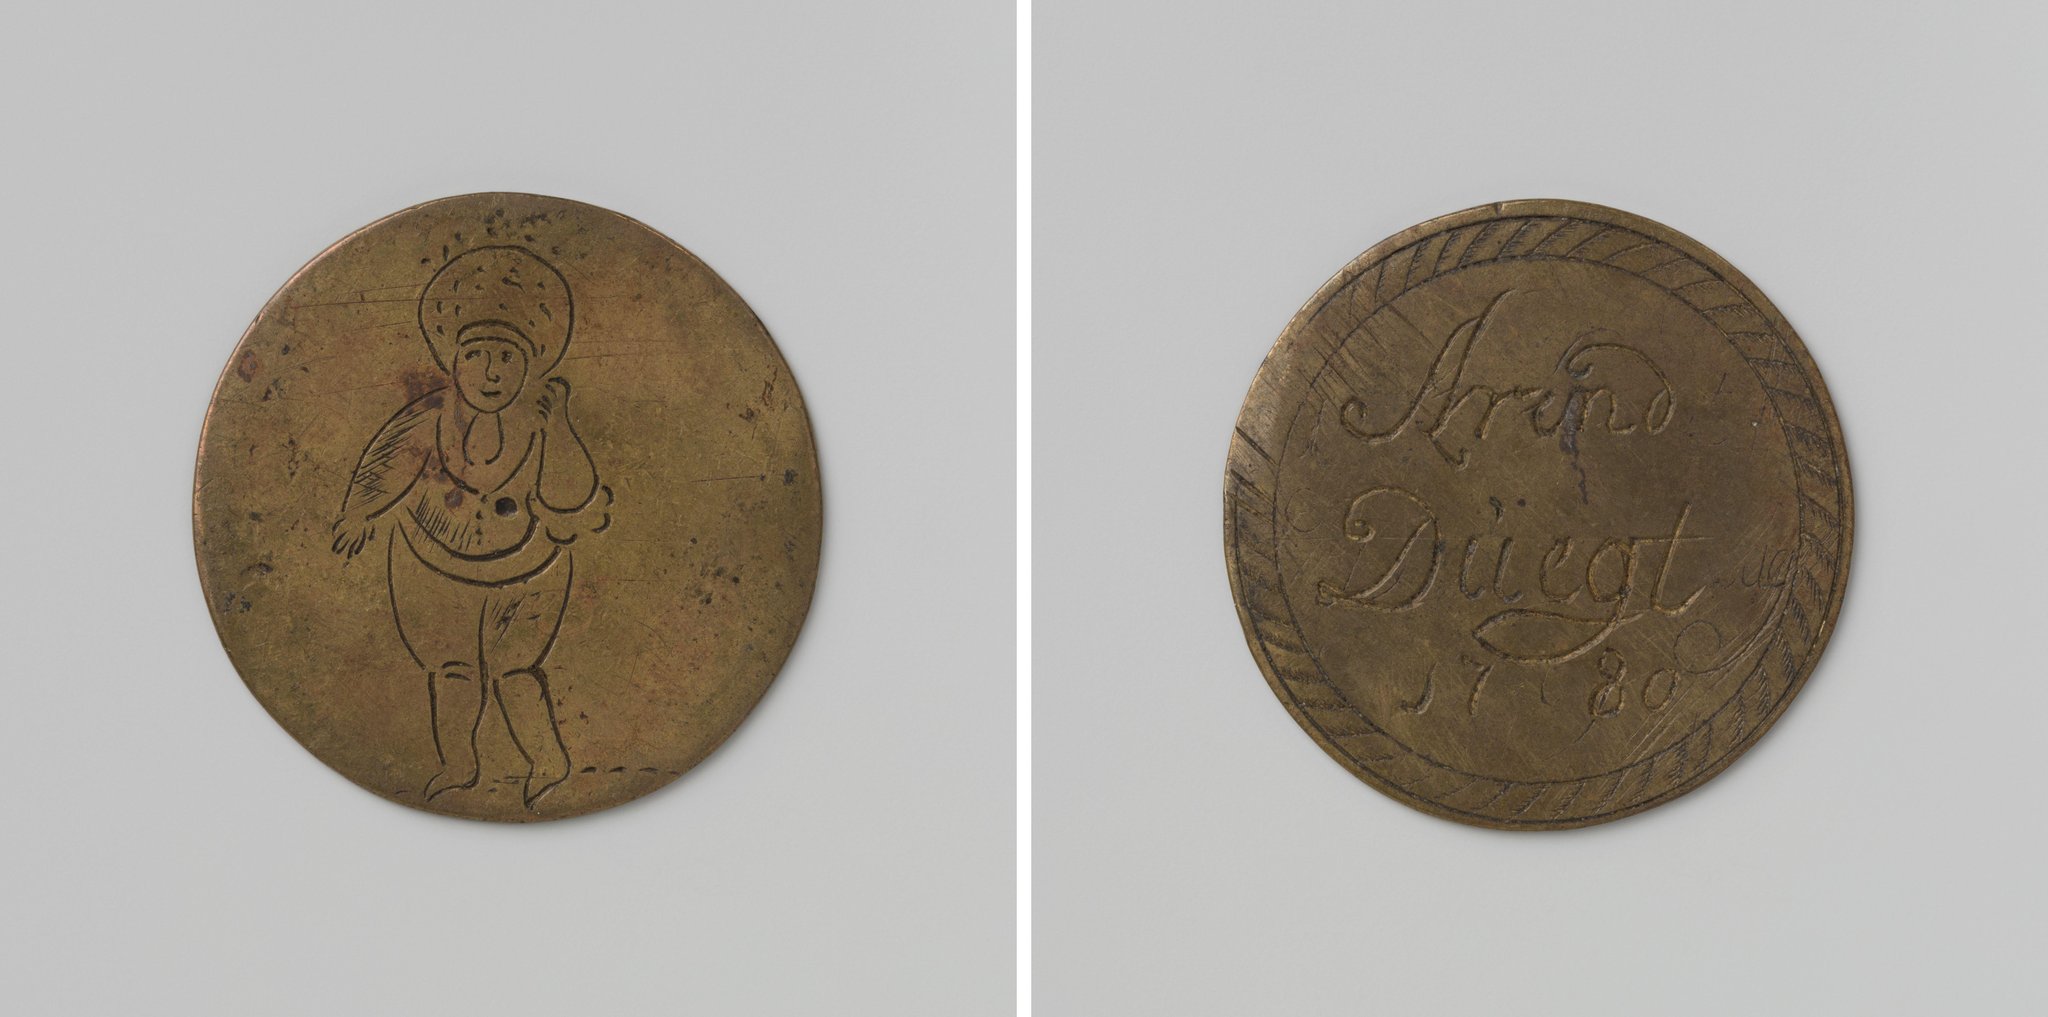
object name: medal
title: Korendragersgilde van Enkhuizen, gildepenning van Arend Duegt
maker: Anonymous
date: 1780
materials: brass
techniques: engraving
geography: enkhuizen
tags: enkhuizen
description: Messing penning. Voorzijde: korendrager met zak op nek en enigszins geheven linkerarm. Keerzijde: opschrift binnen kabelrand